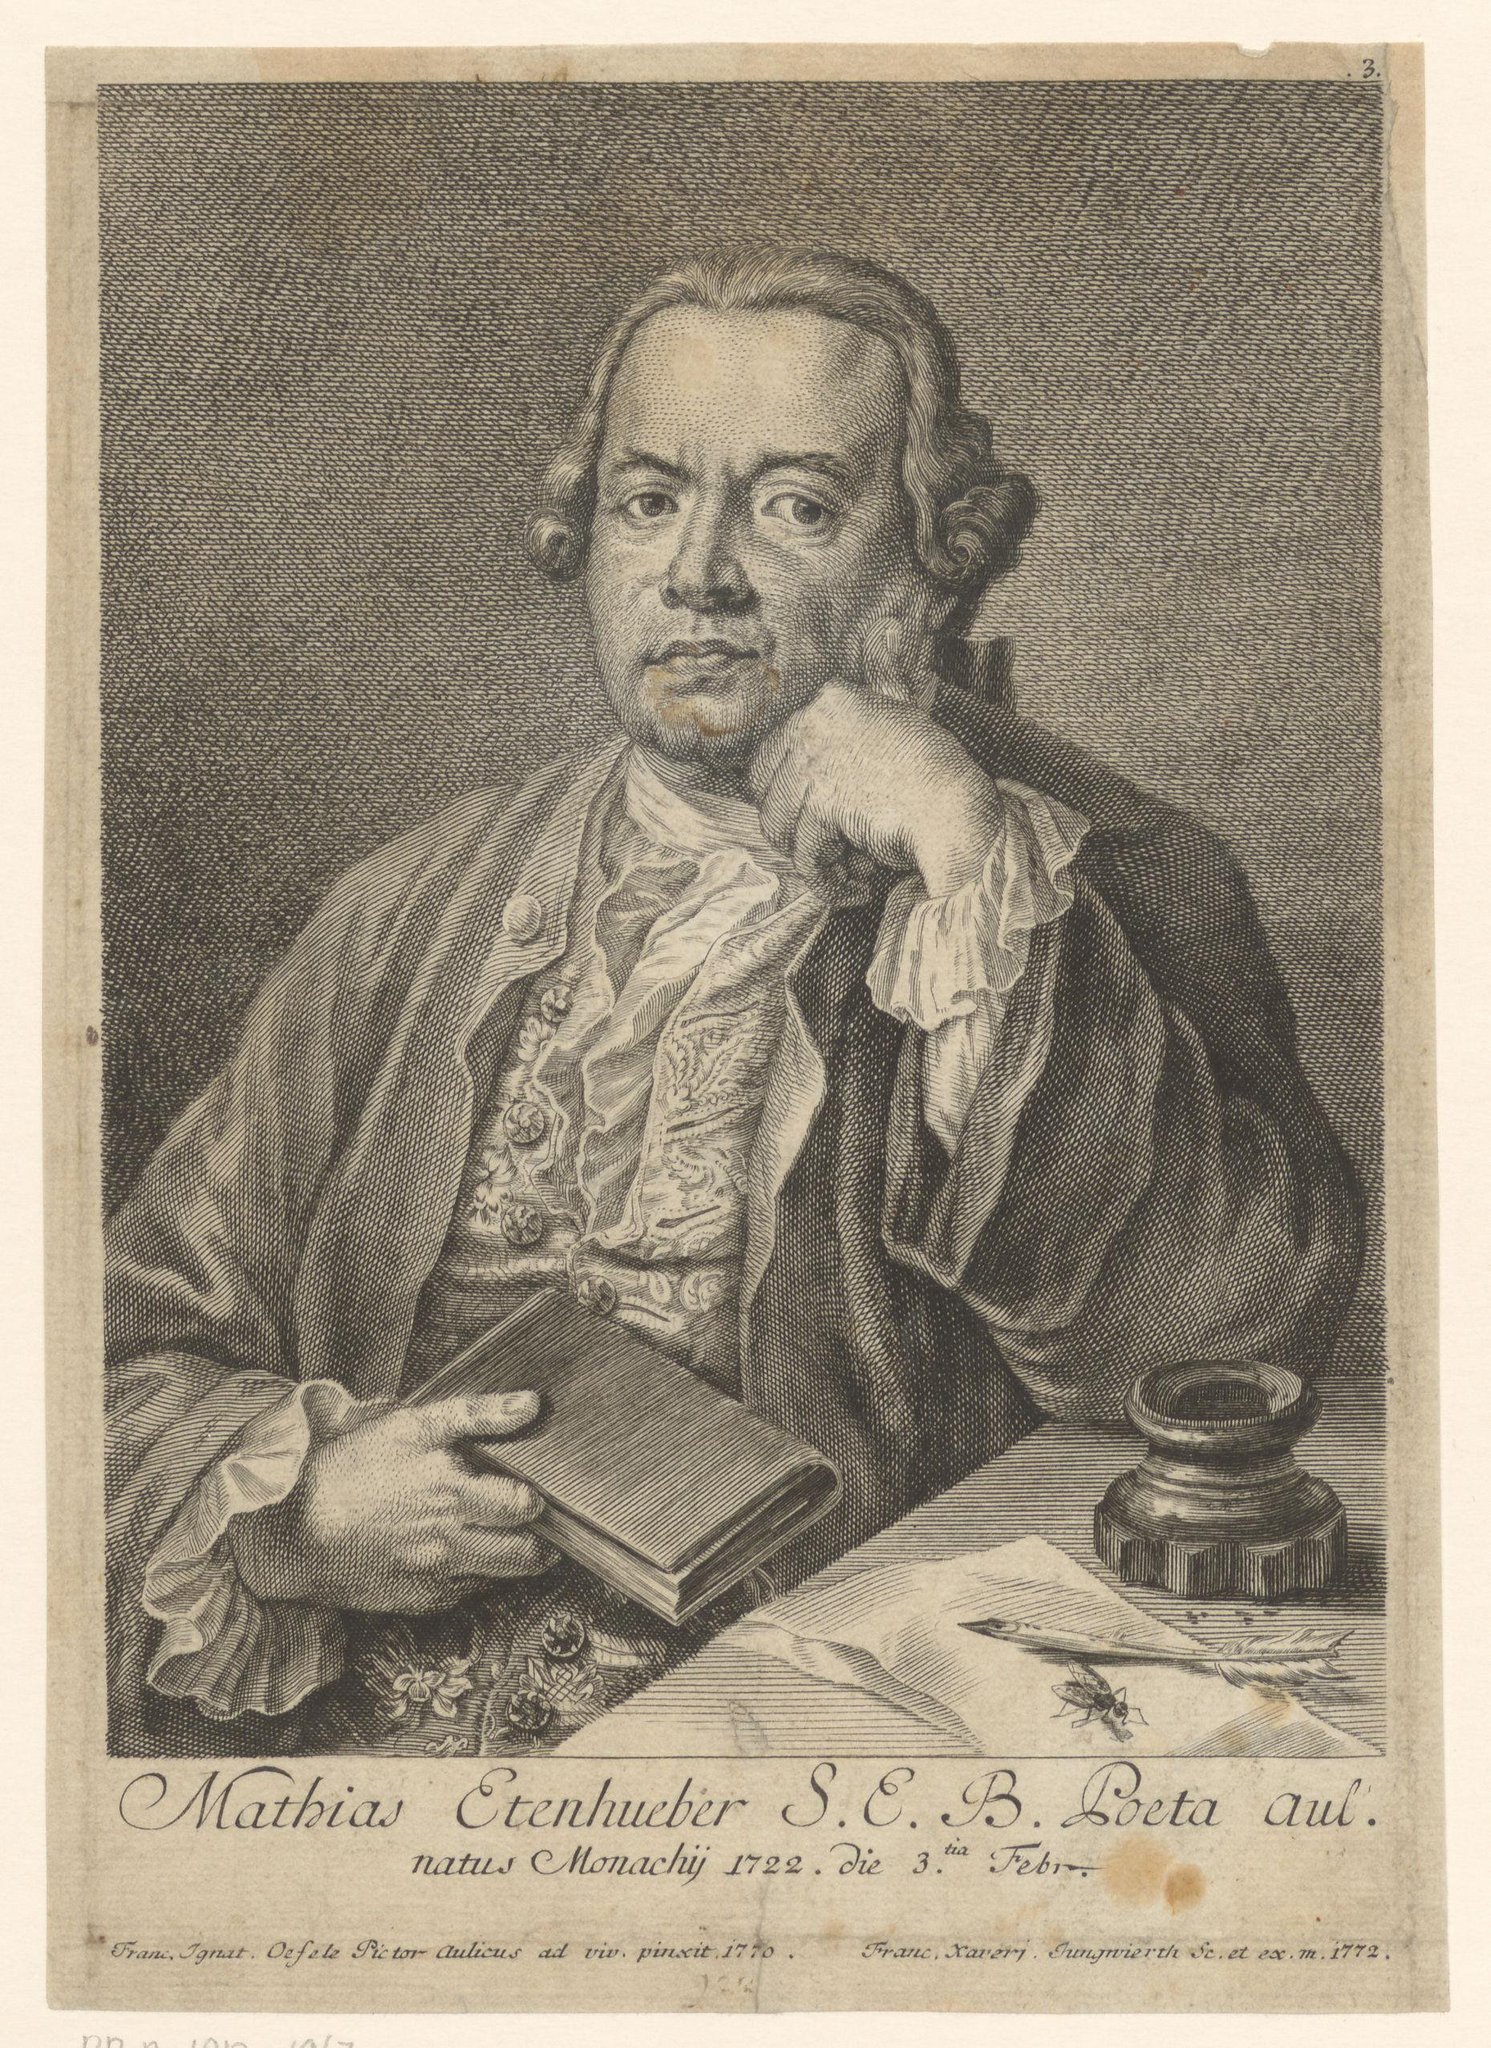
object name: print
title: Portret van Matthias Ettenhueber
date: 1772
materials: paper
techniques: engraving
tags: writing tools, historical persons, portrait of a writer, insects: fly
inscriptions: collector's mark: Lugt 2228